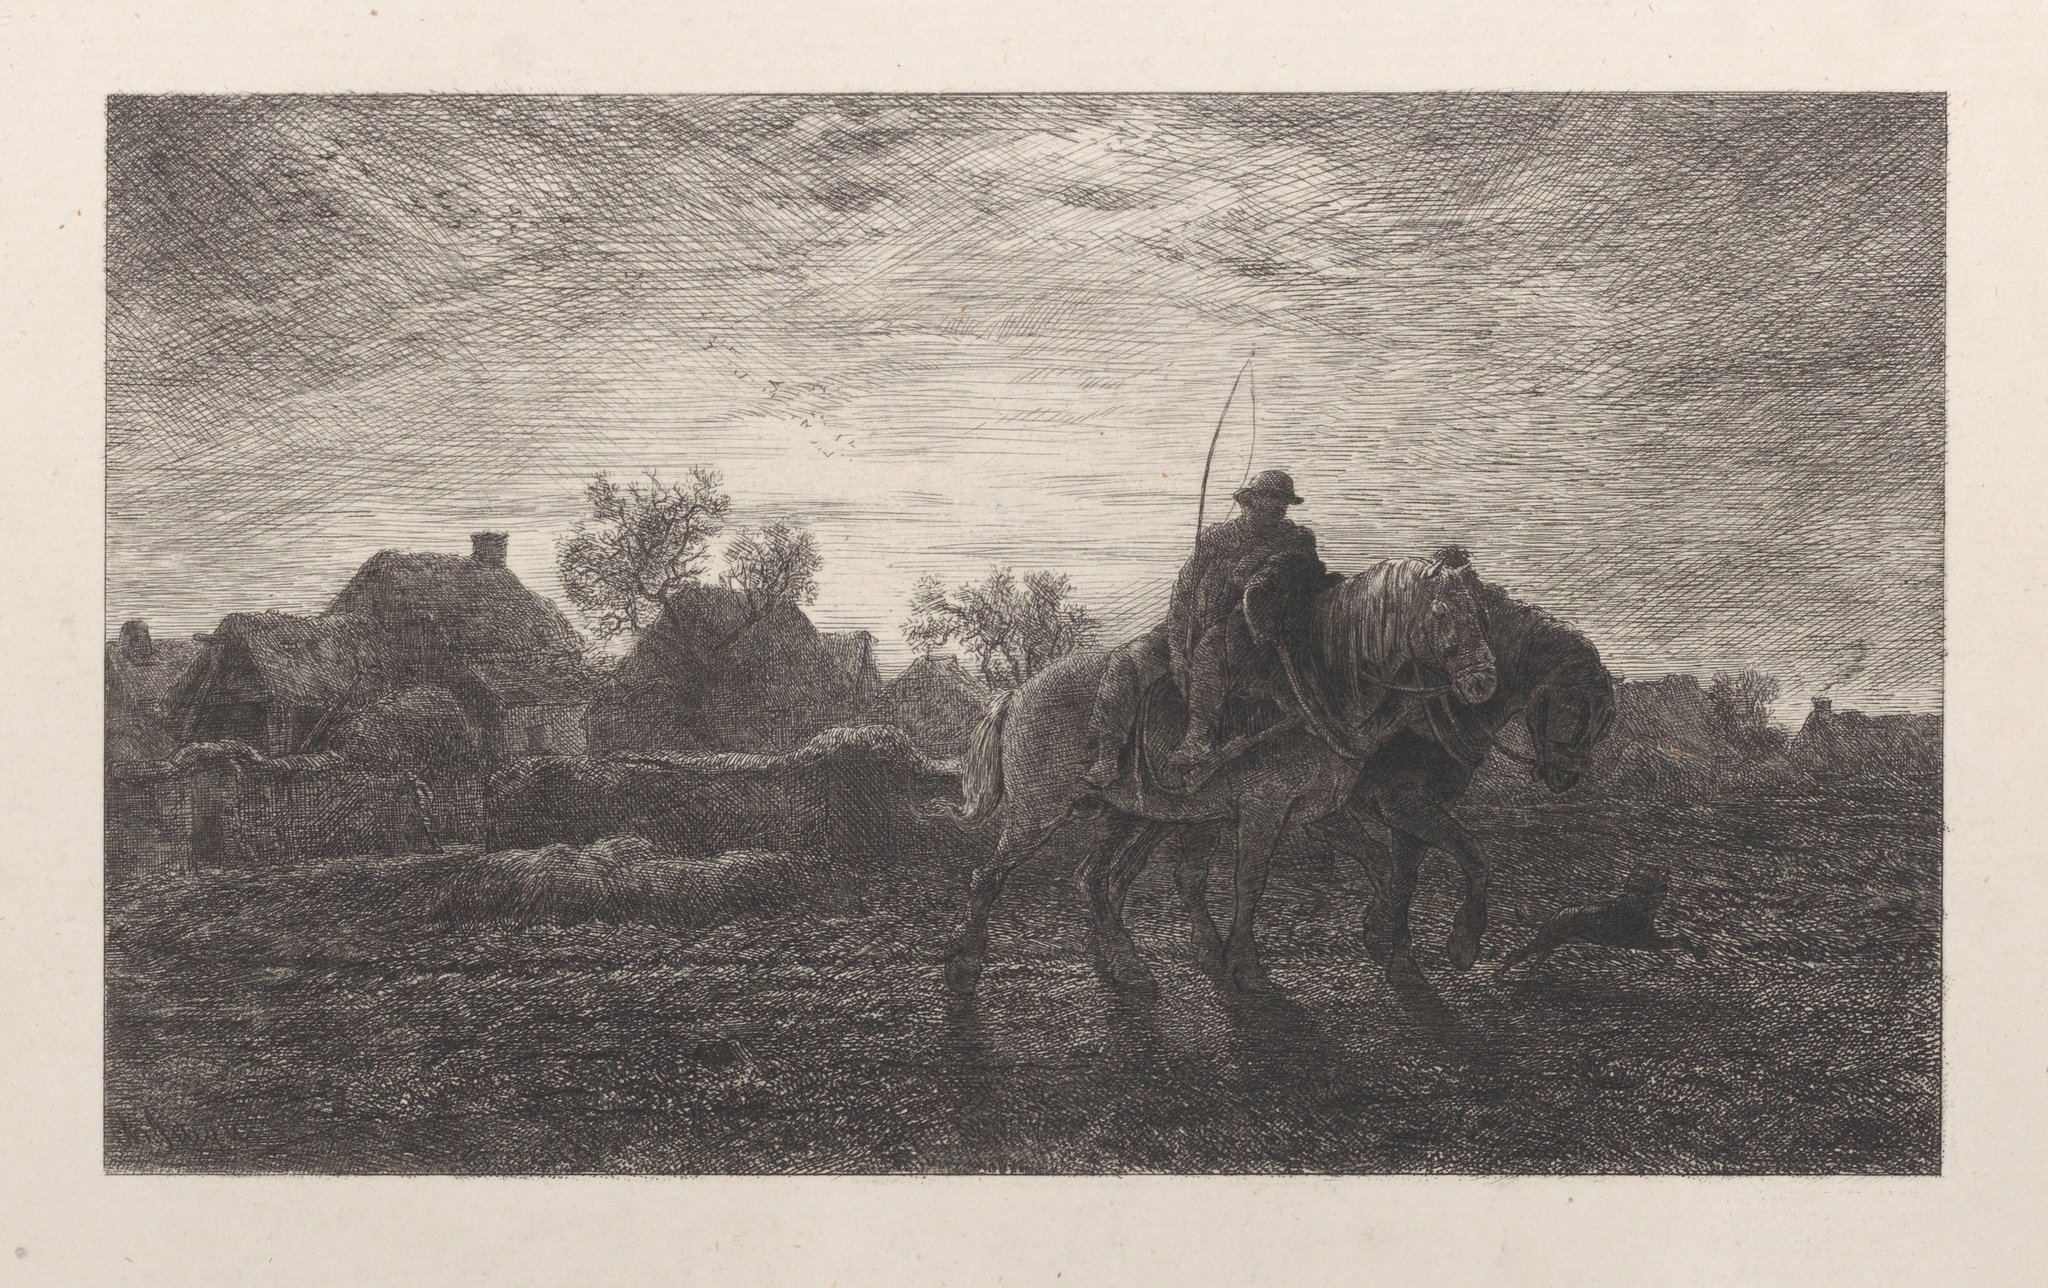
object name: print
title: The Morning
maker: charles émile jacque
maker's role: artist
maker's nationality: french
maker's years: 1813-1894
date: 1864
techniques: etching